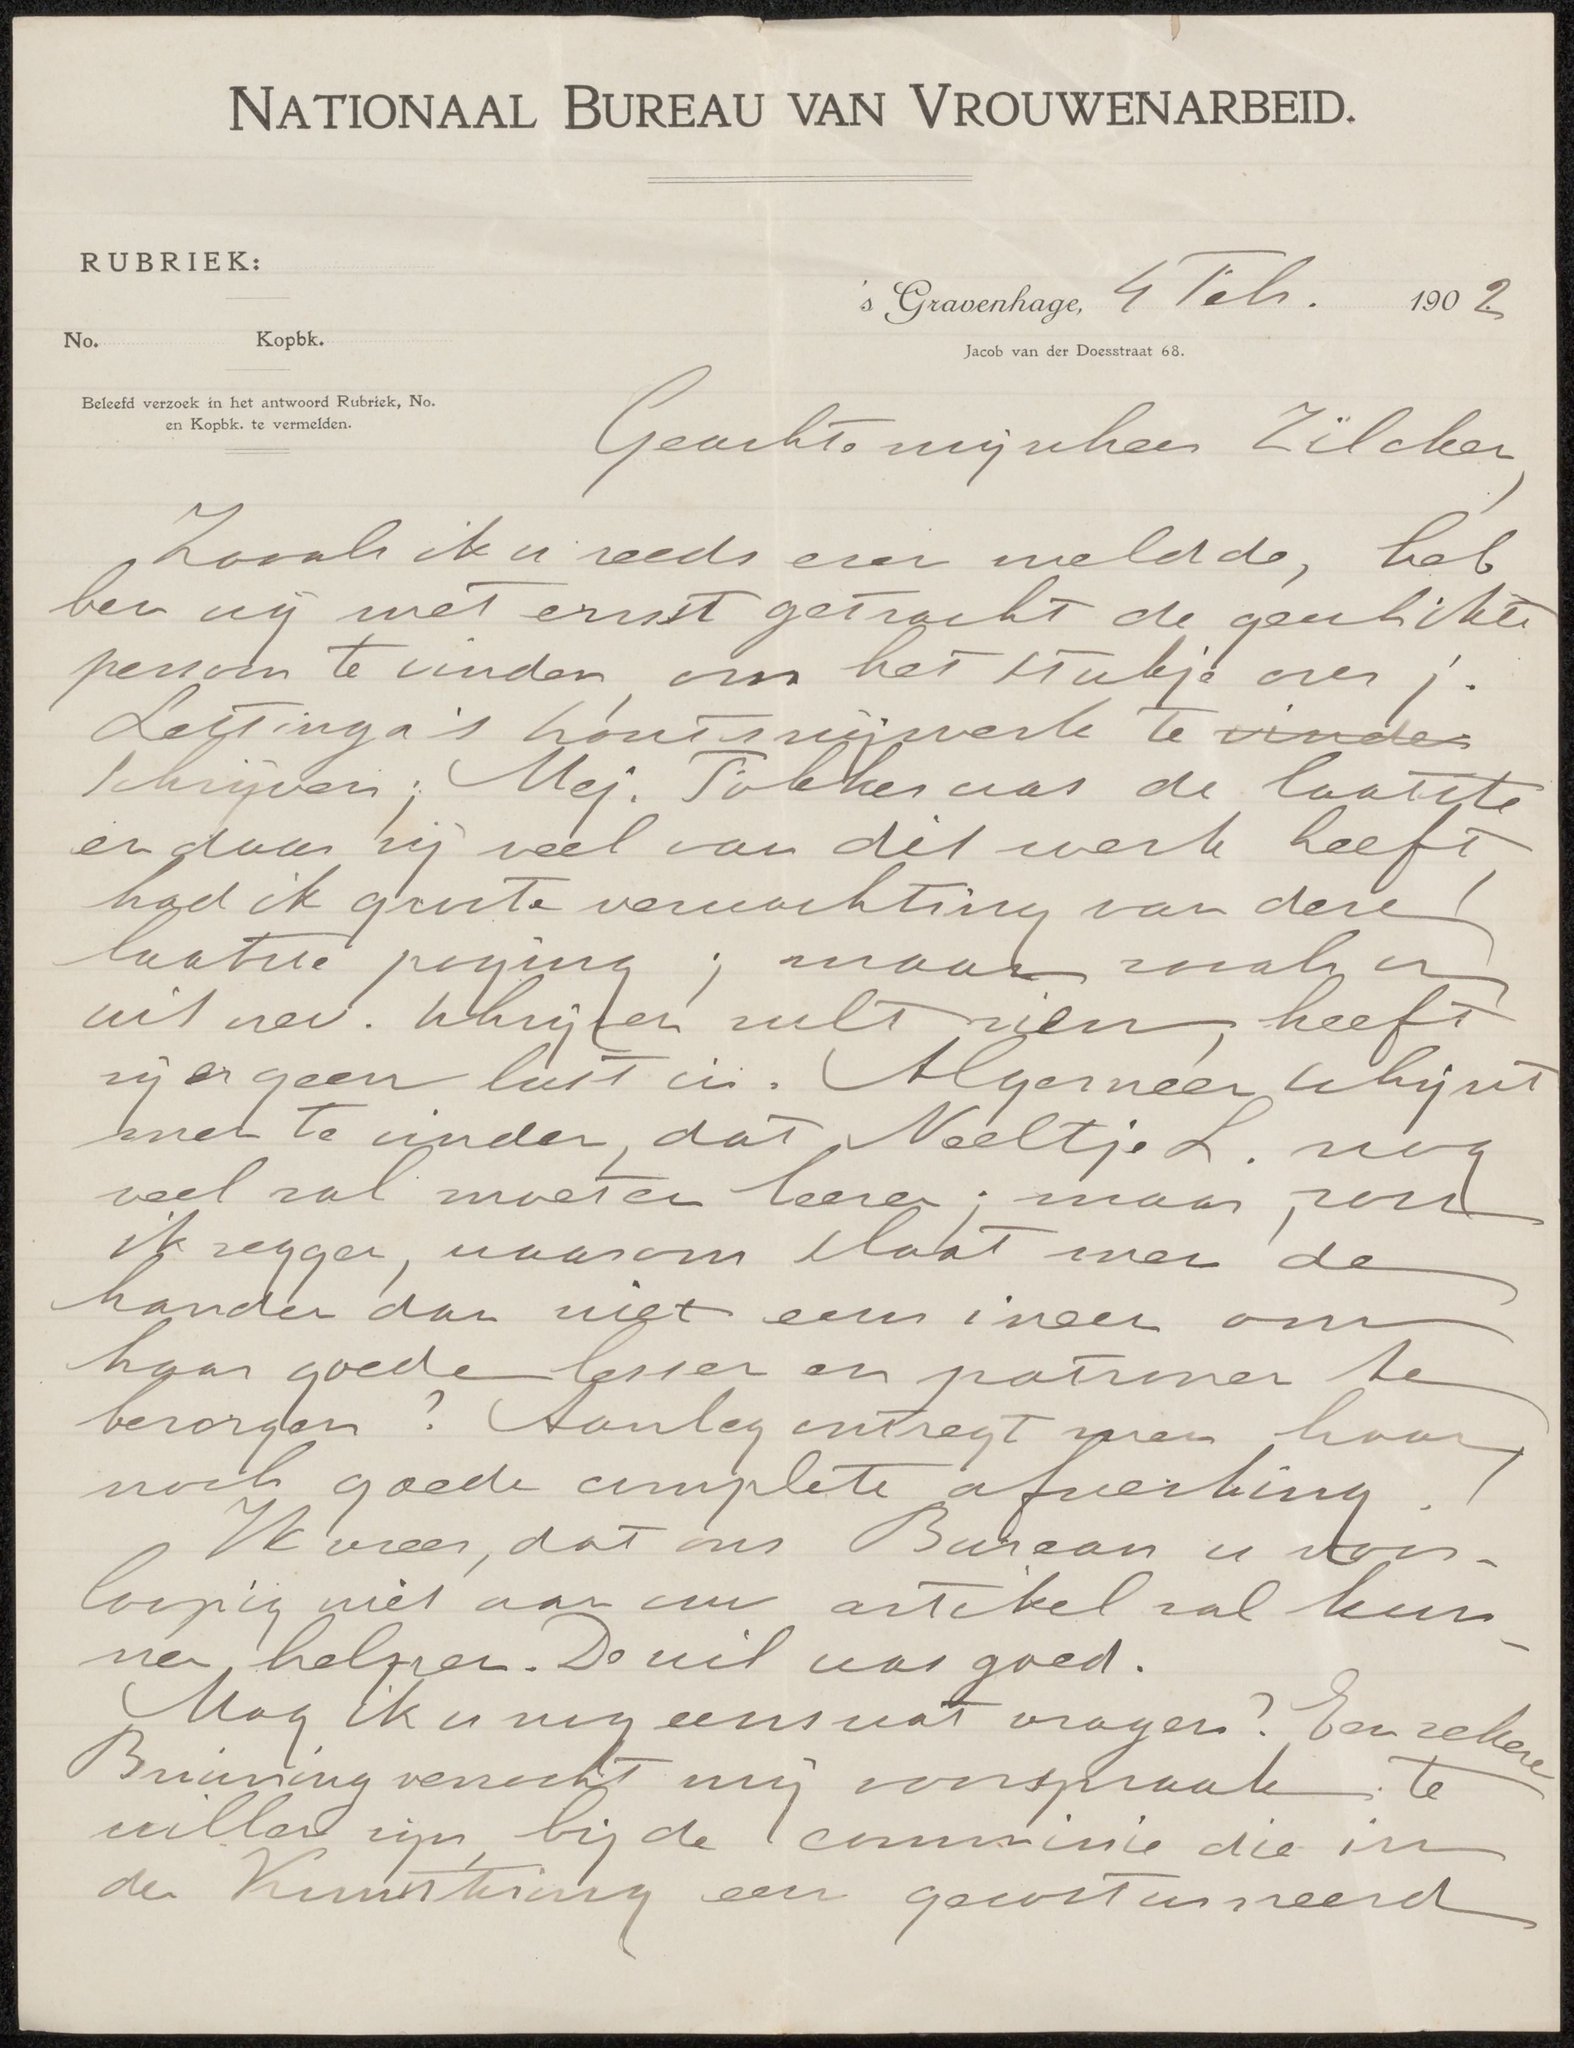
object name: letter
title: Brief aan Philip Zilcken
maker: suze groshans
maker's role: schrijver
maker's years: 1863-1944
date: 1902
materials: ink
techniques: pen, printing, writing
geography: the hague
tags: textile artist, neeltje lettinga, nelly fokker, the hague, draughtsman, philip zilcken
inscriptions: collector's mark: ‘RPK’